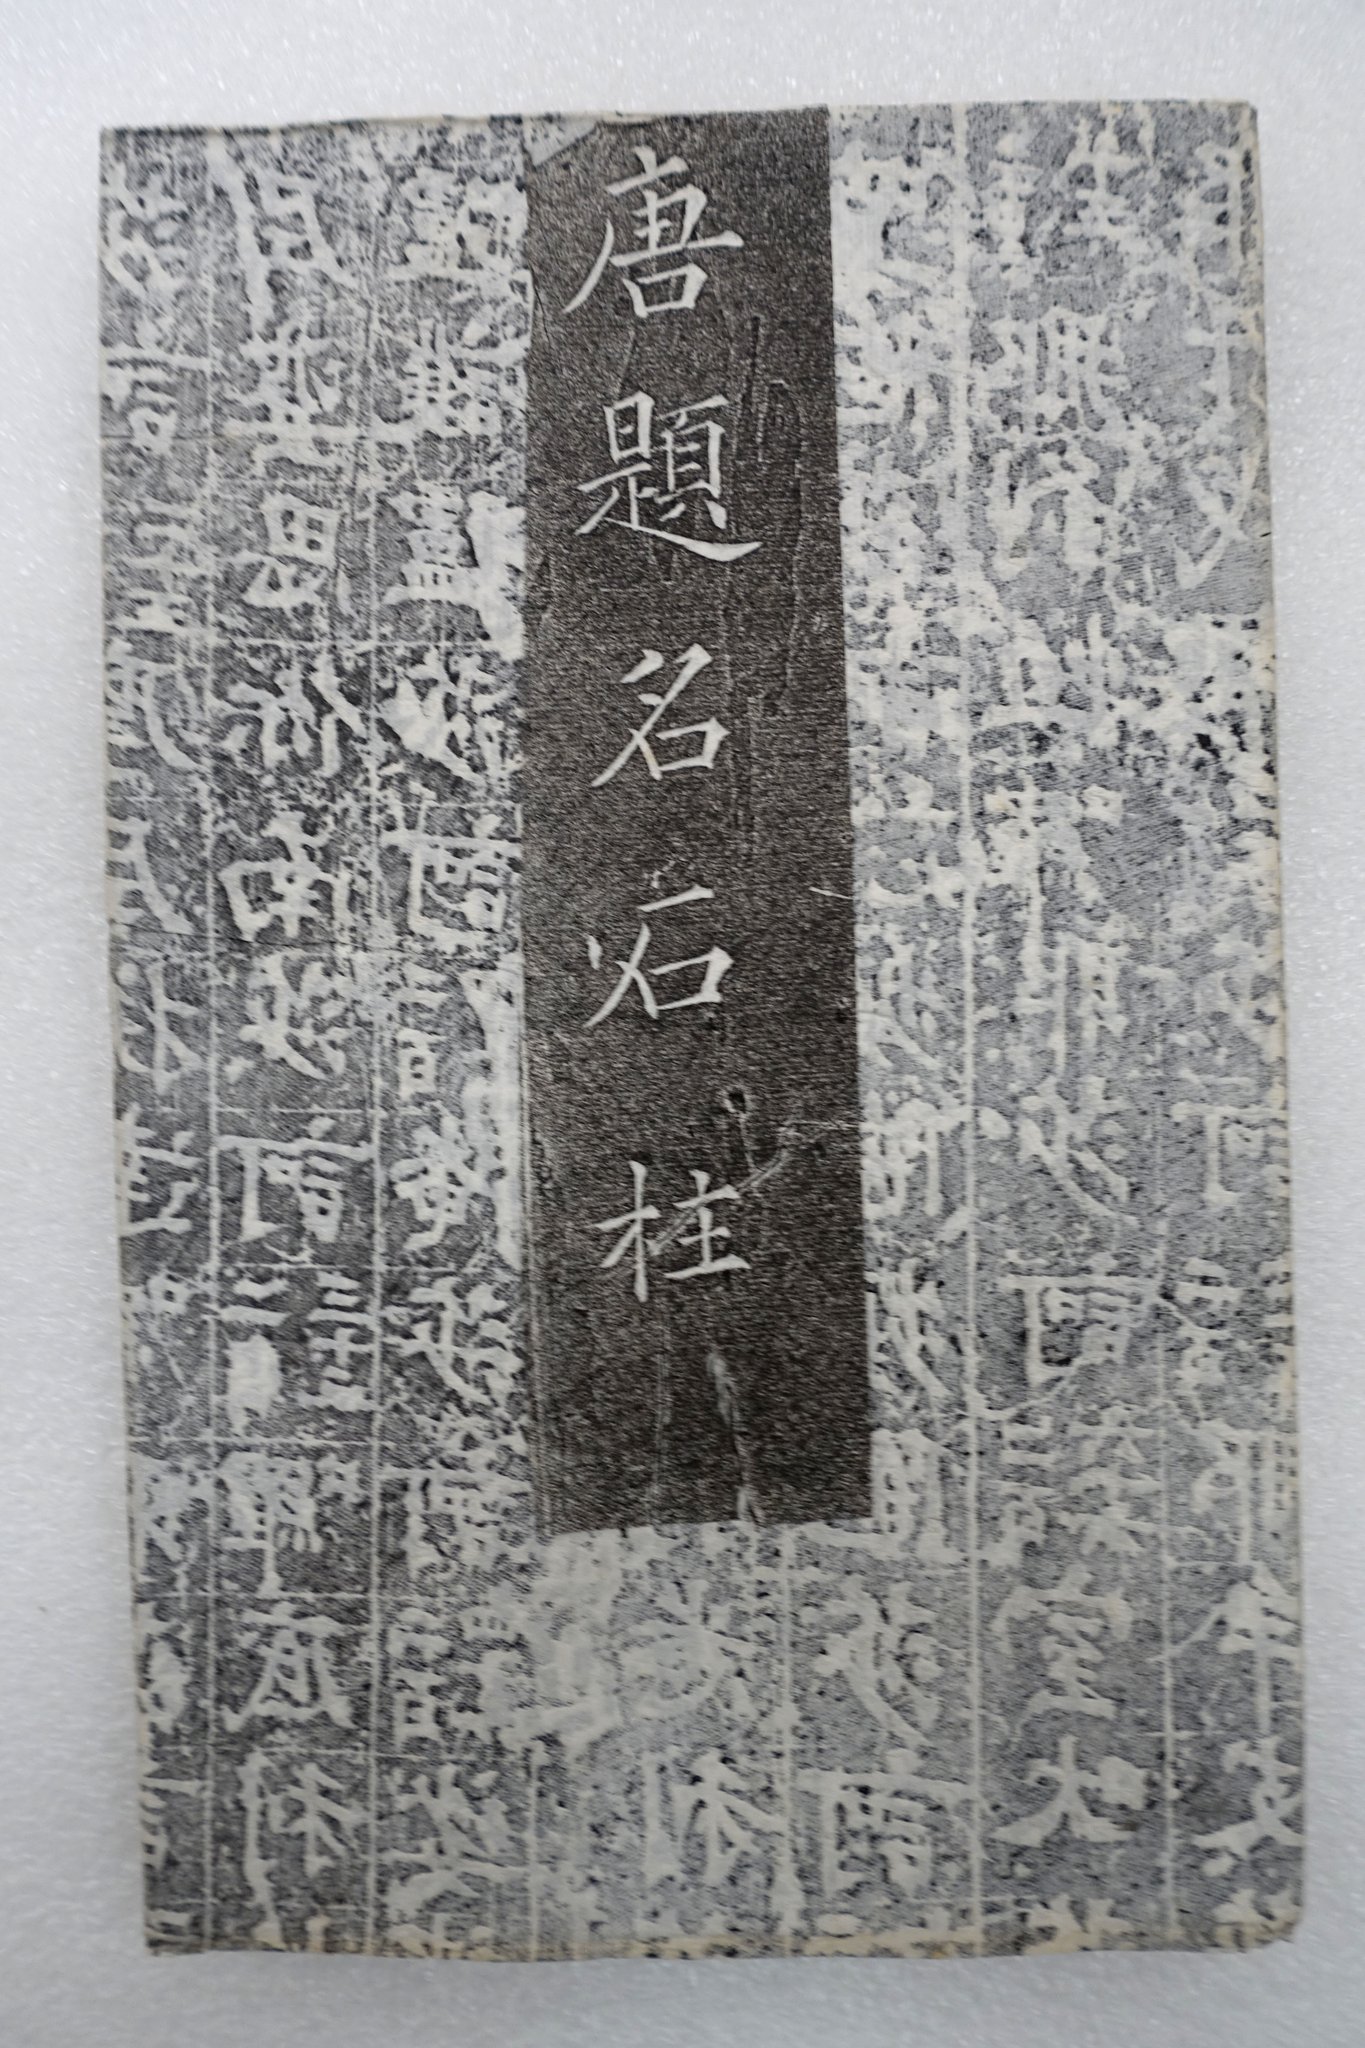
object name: rubbing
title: Tang Stone Pillar Inscribed with Names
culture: chinese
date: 1901-2000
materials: ink, paper